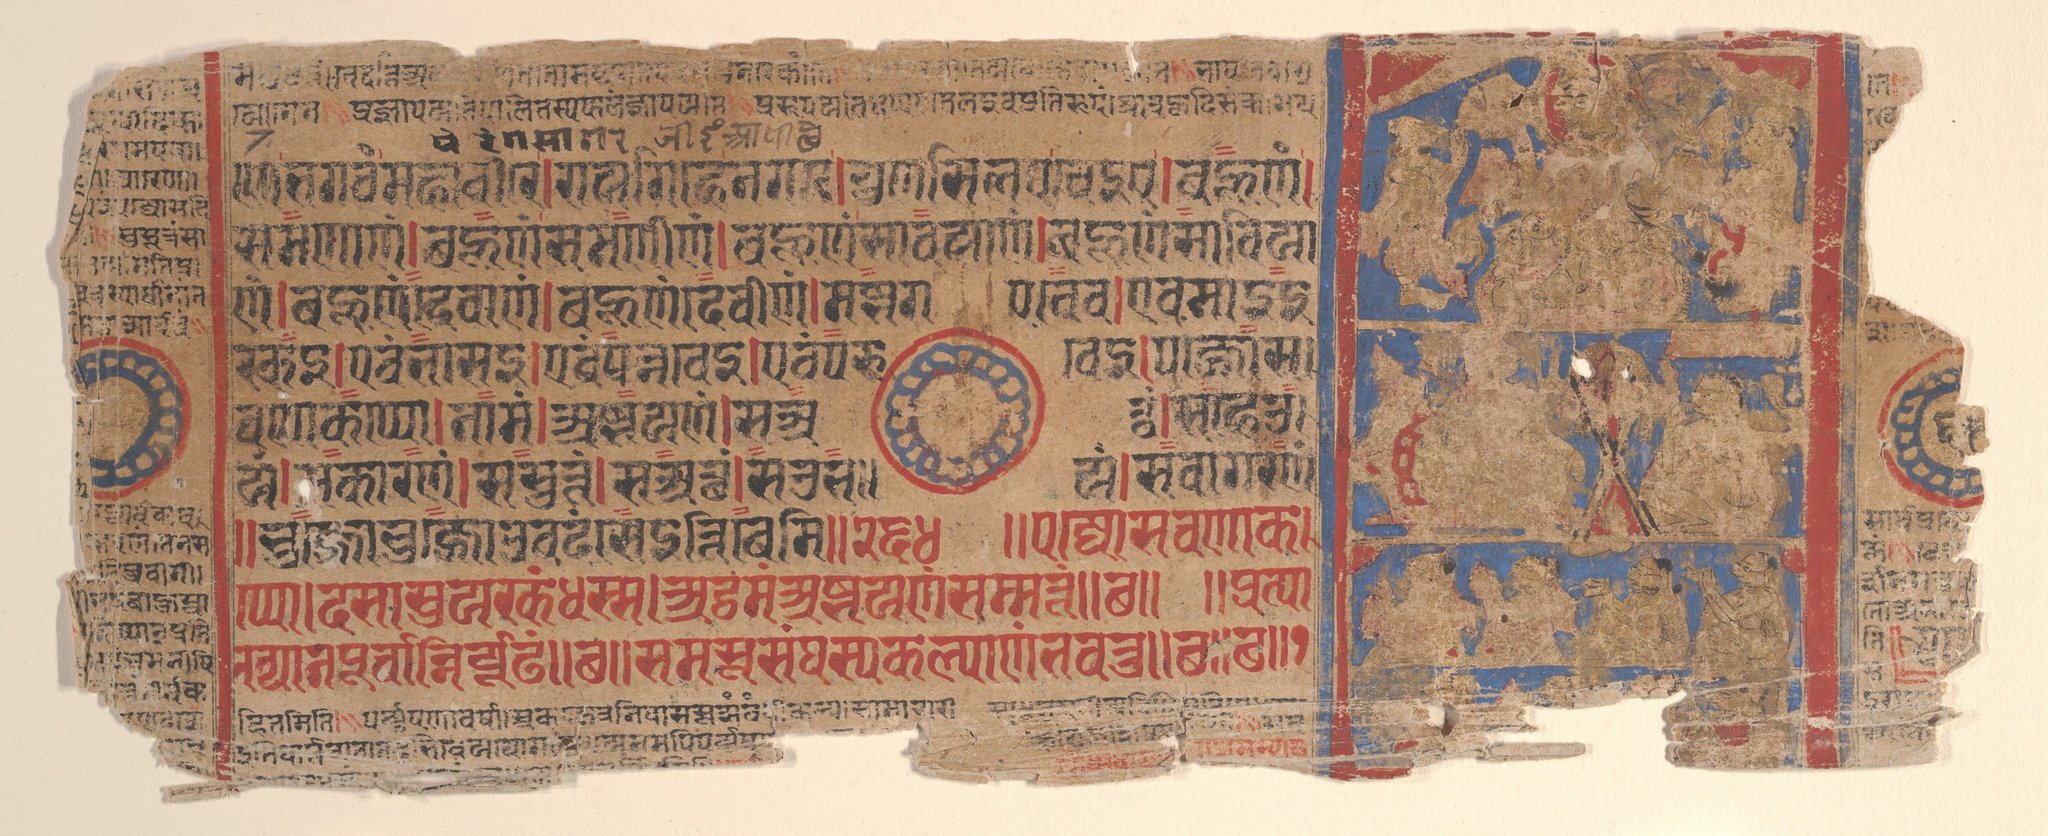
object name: folio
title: Leaf from a Kalpa Sutra (Jain Book of Rituals)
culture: indian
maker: bhadrabahu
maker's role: artist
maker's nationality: indian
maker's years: 356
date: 1401-1500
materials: gold, ink, paper, watercolor